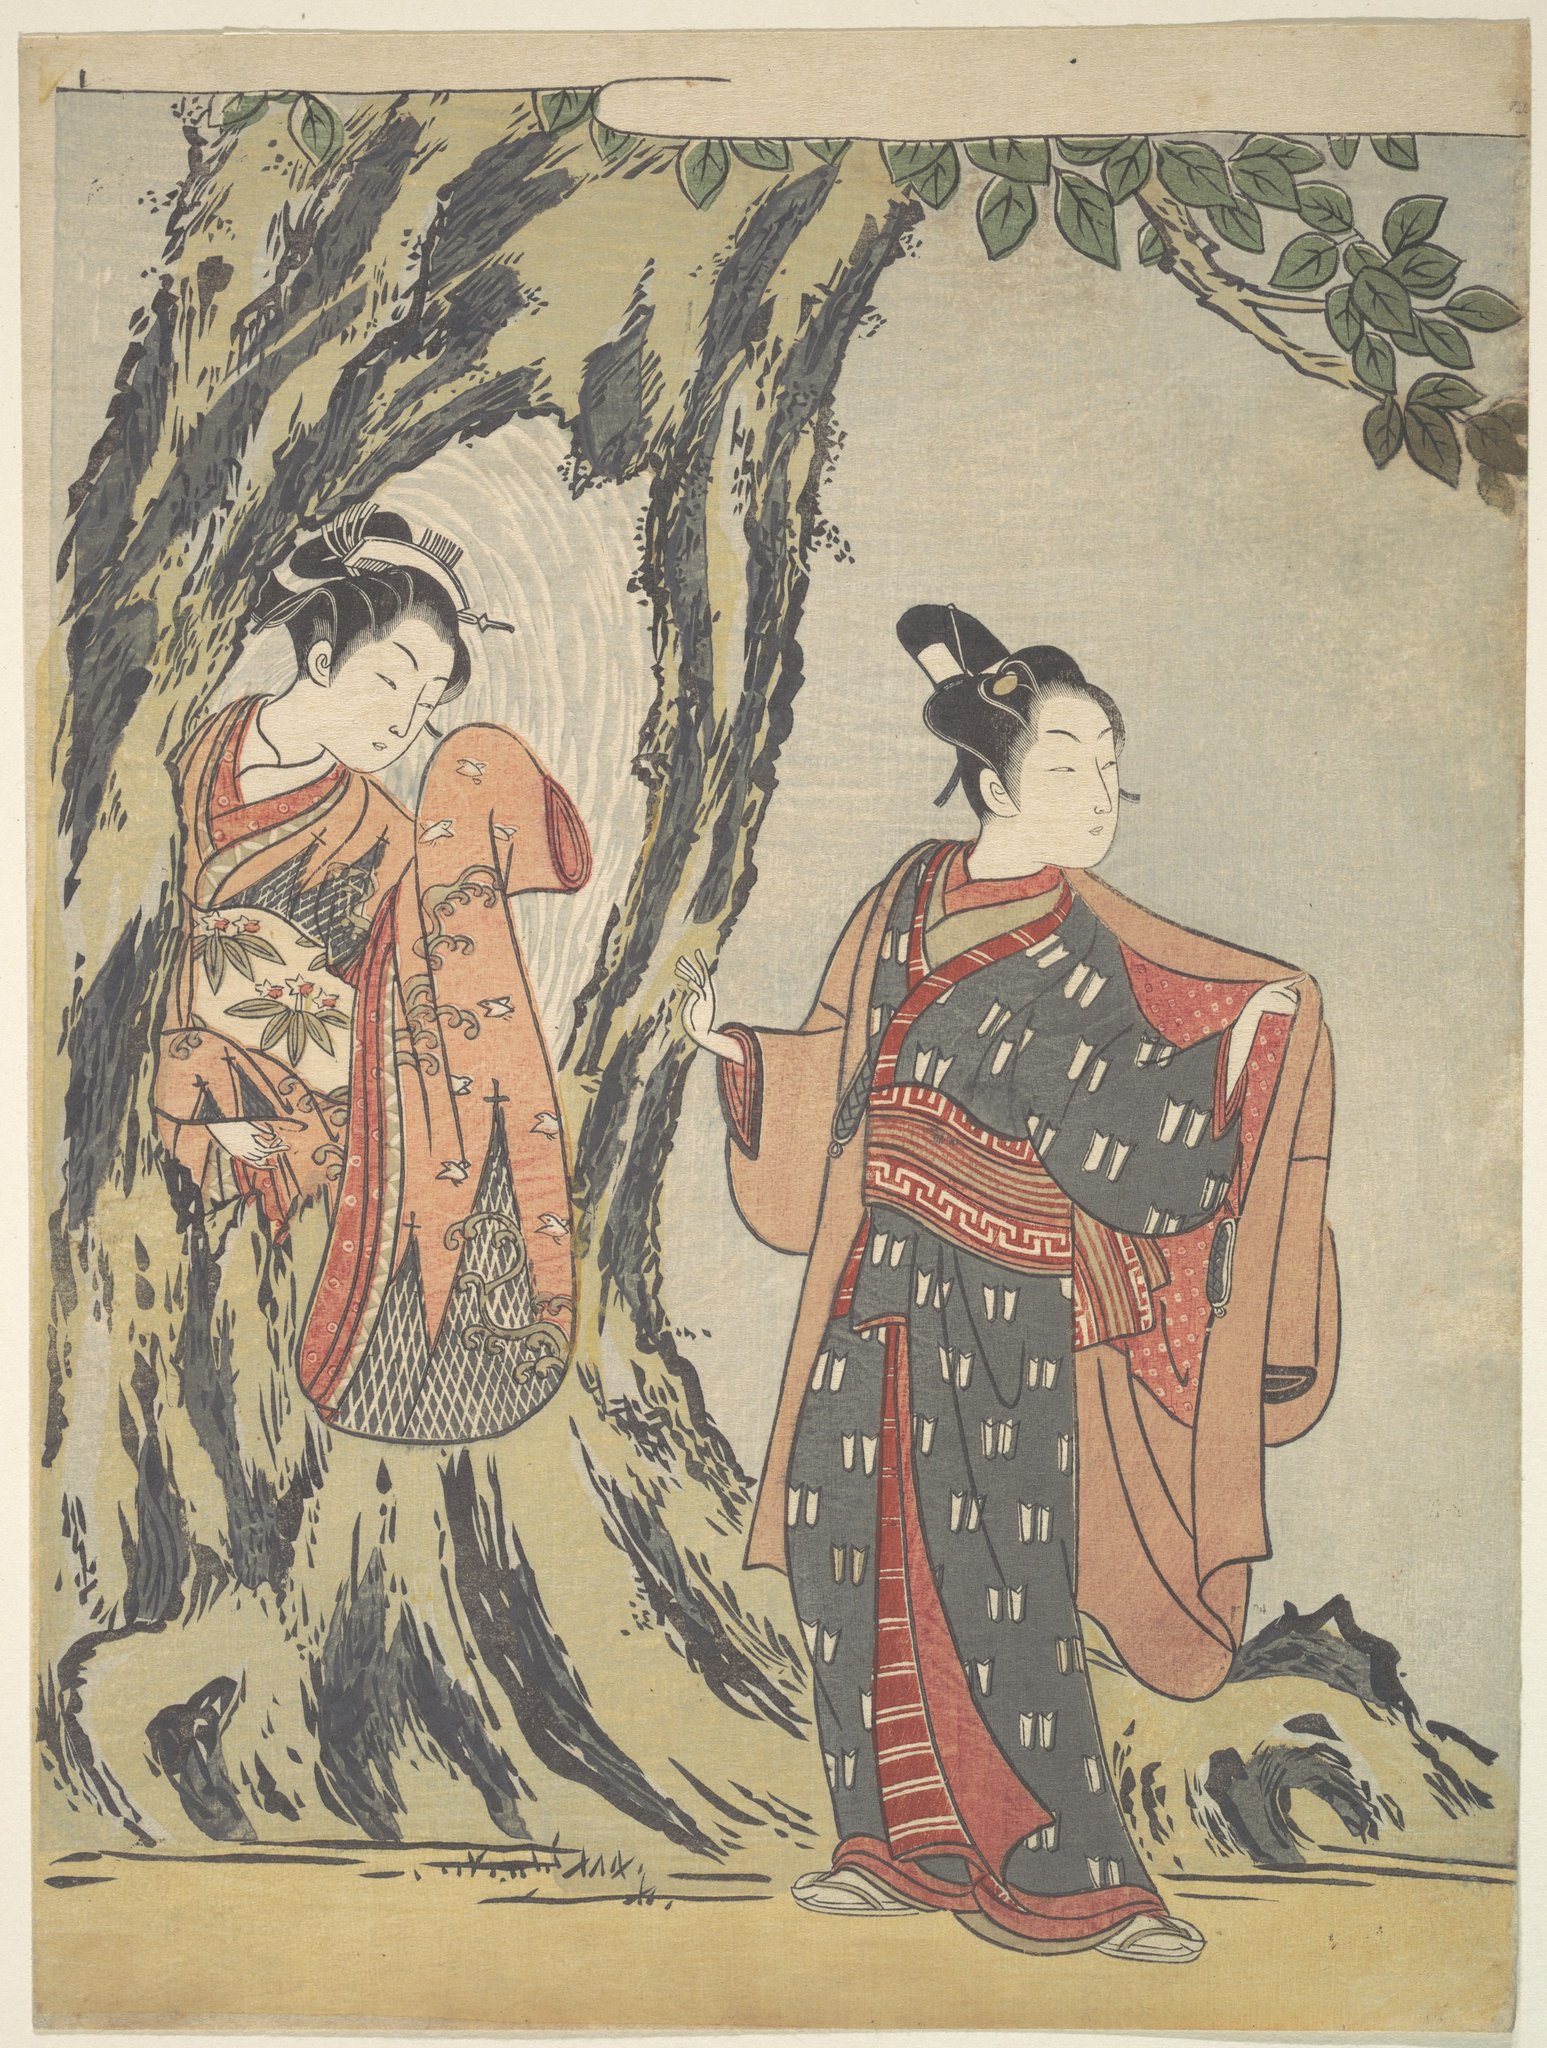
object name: print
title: Two Young People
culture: japanese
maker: suzuki harunobu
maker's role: artist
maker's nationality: japanese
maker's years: 1725-1770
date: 1725-1770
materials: ink, paper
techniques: woodblock print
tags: men,women